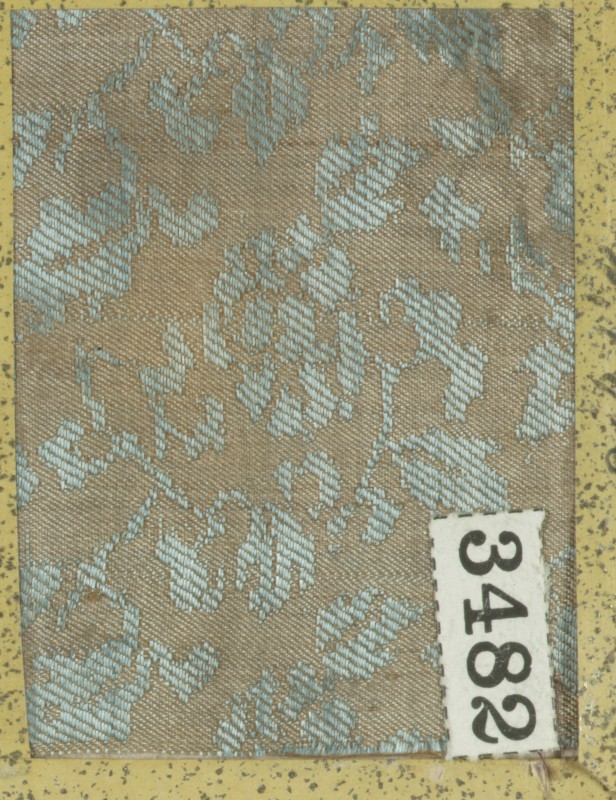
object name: sample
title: Textile Sample from Sample Book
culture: japanese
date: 1801-1900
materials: silk